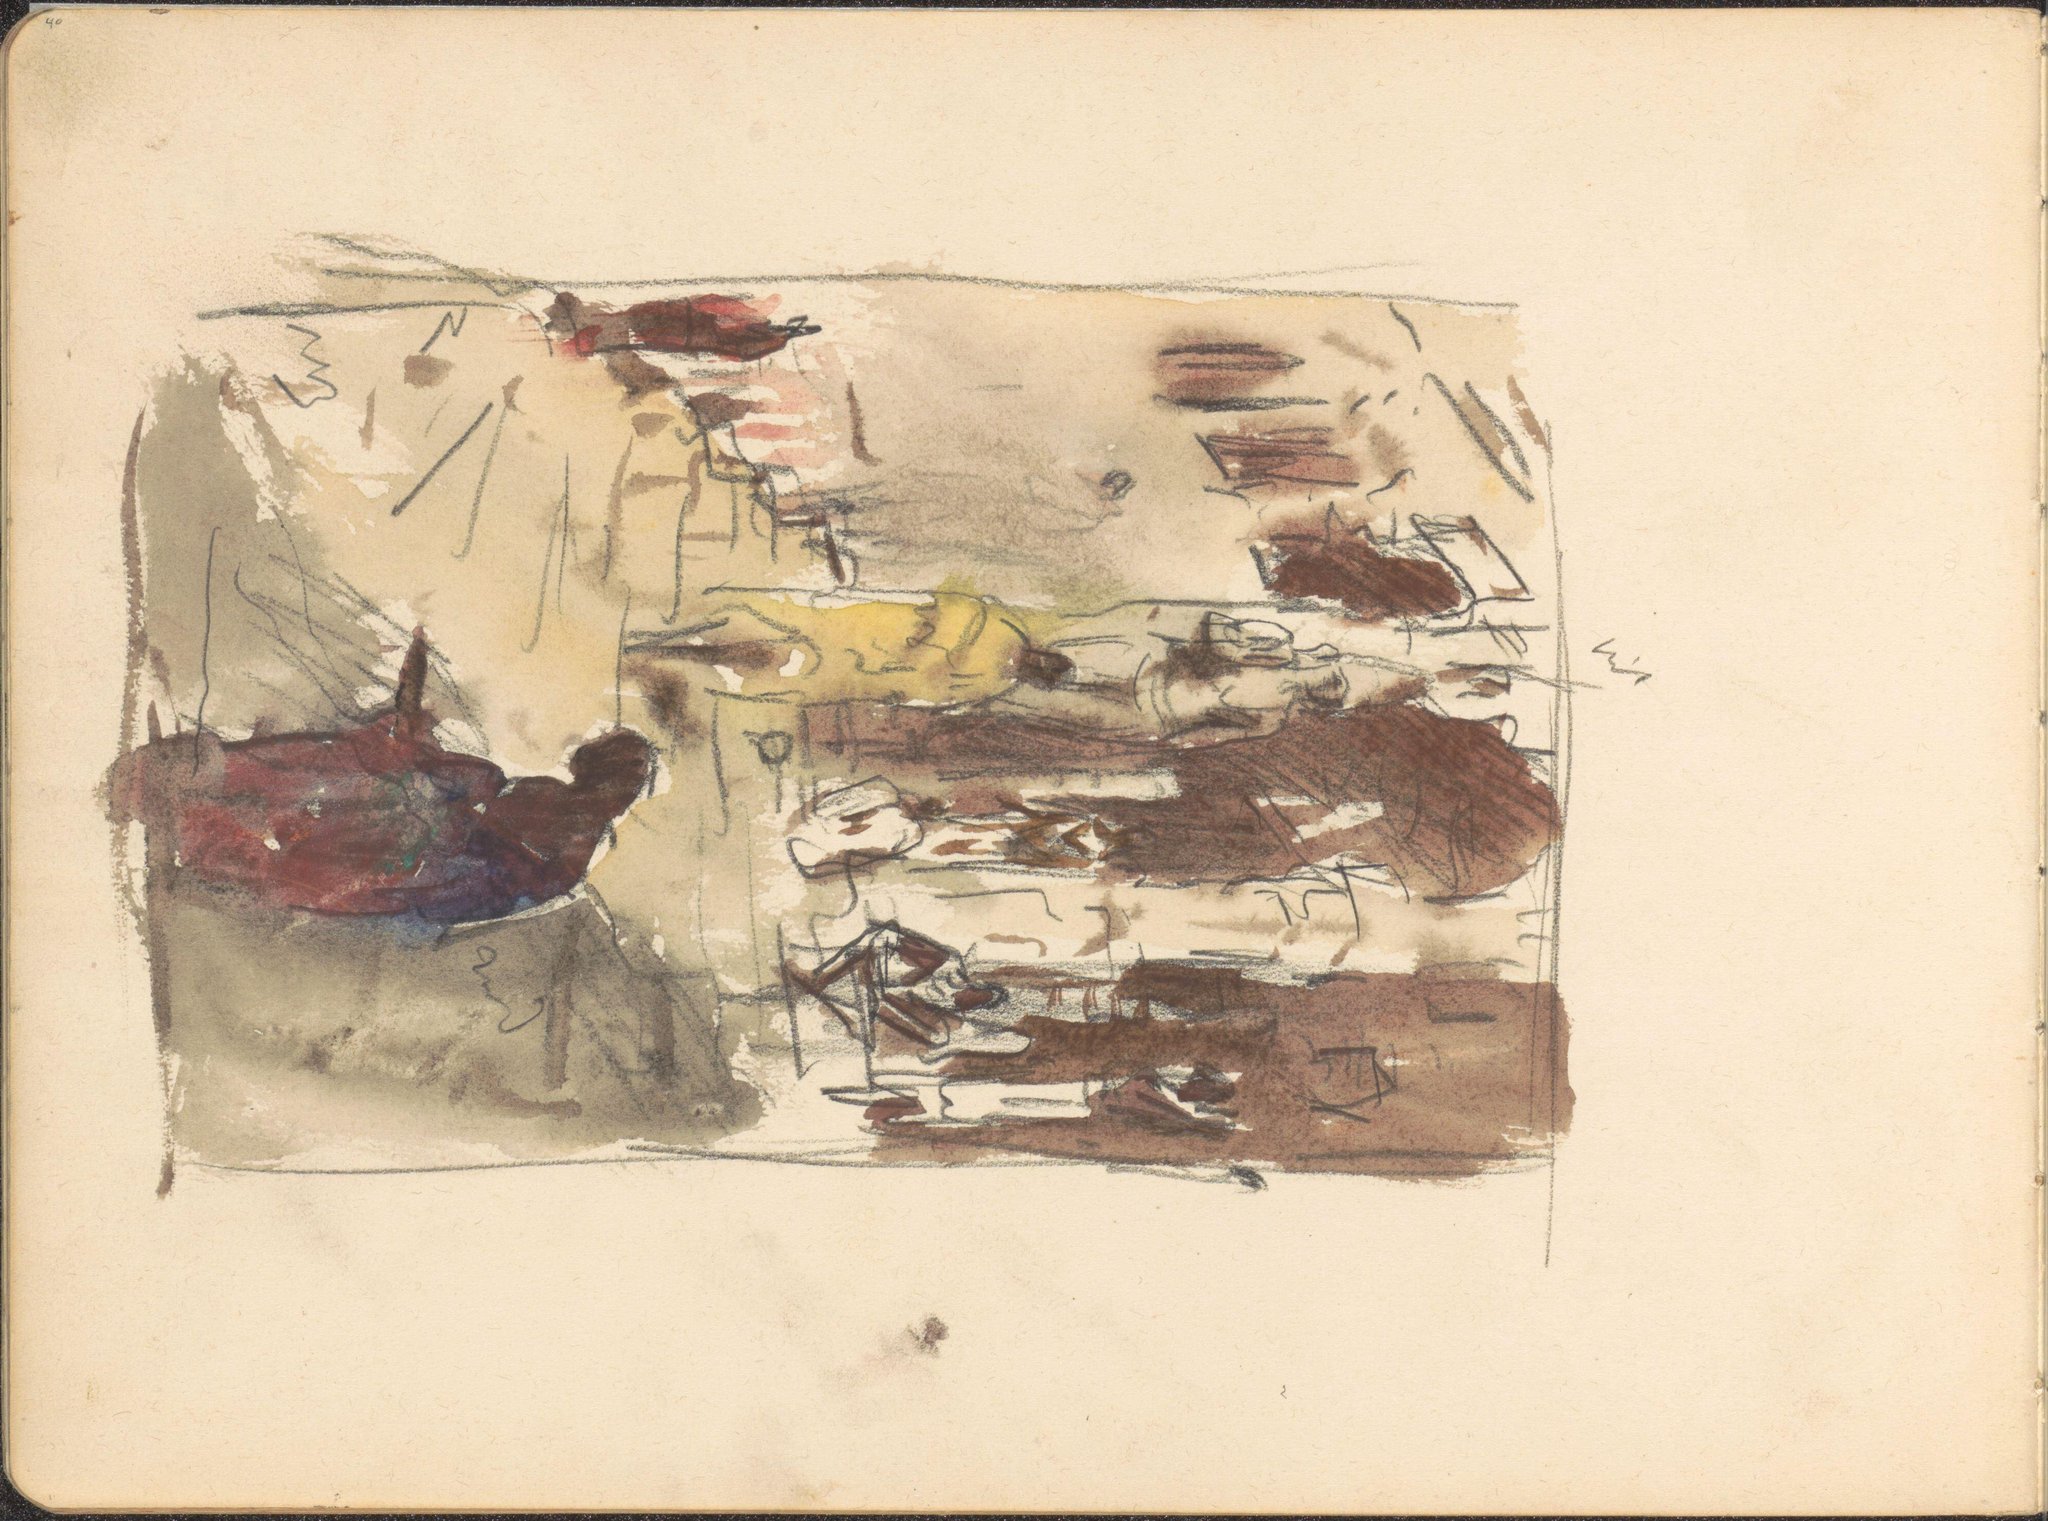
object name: sketchbook leaf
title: Figuren op een tempeltrap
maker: marius bauer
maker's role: draughtsman, print maker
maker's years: 1867-1932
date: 1924-1925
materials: chalk, paper, watercolor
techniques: brush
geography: sri lanka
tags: temple, shrine ~ hinduism, buddhism, jainism, standing figure, sitting figure, flight of steps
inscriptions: monogram: ‘MB’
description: Tegen een zuil voor de tempel staat een beeldhouwwerk van een Hindoeïstische god. Pagina 40 uit een schetsboek met 20 bladen.